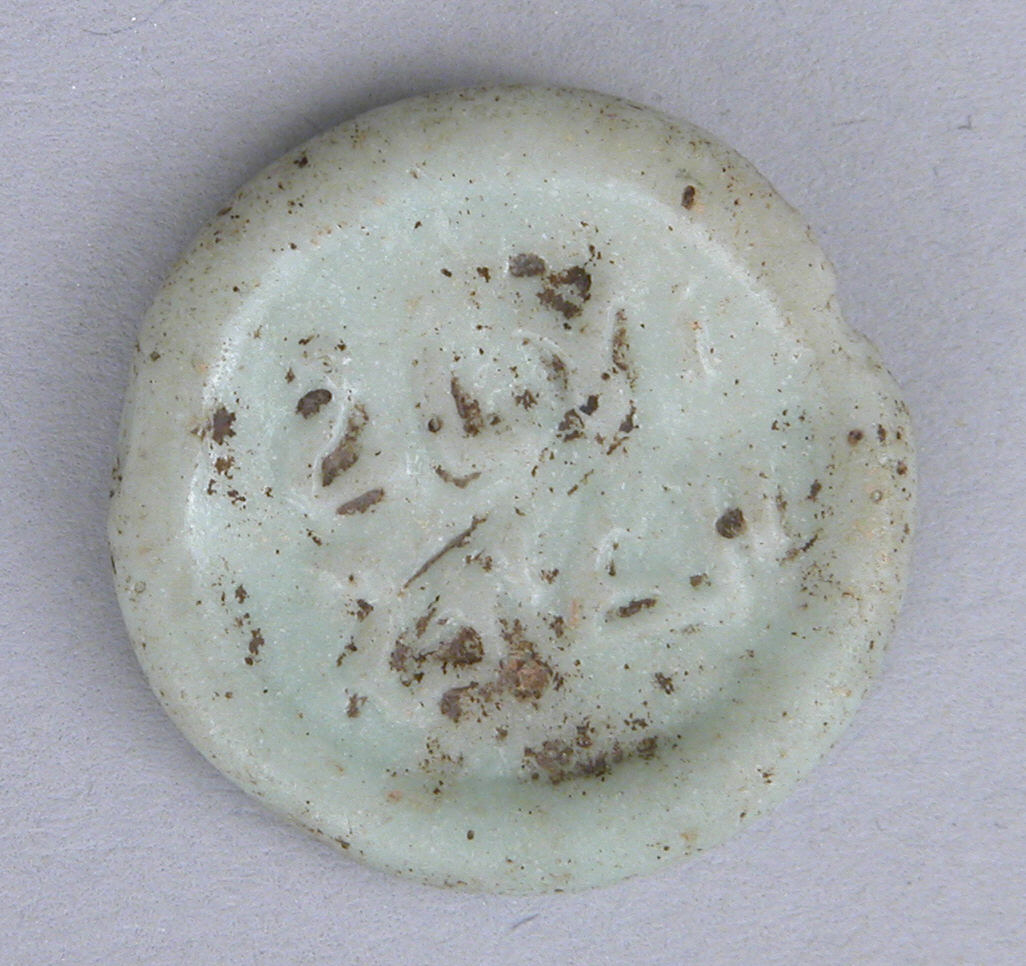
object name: coin weight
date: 1101-1200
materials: glass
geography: egypt